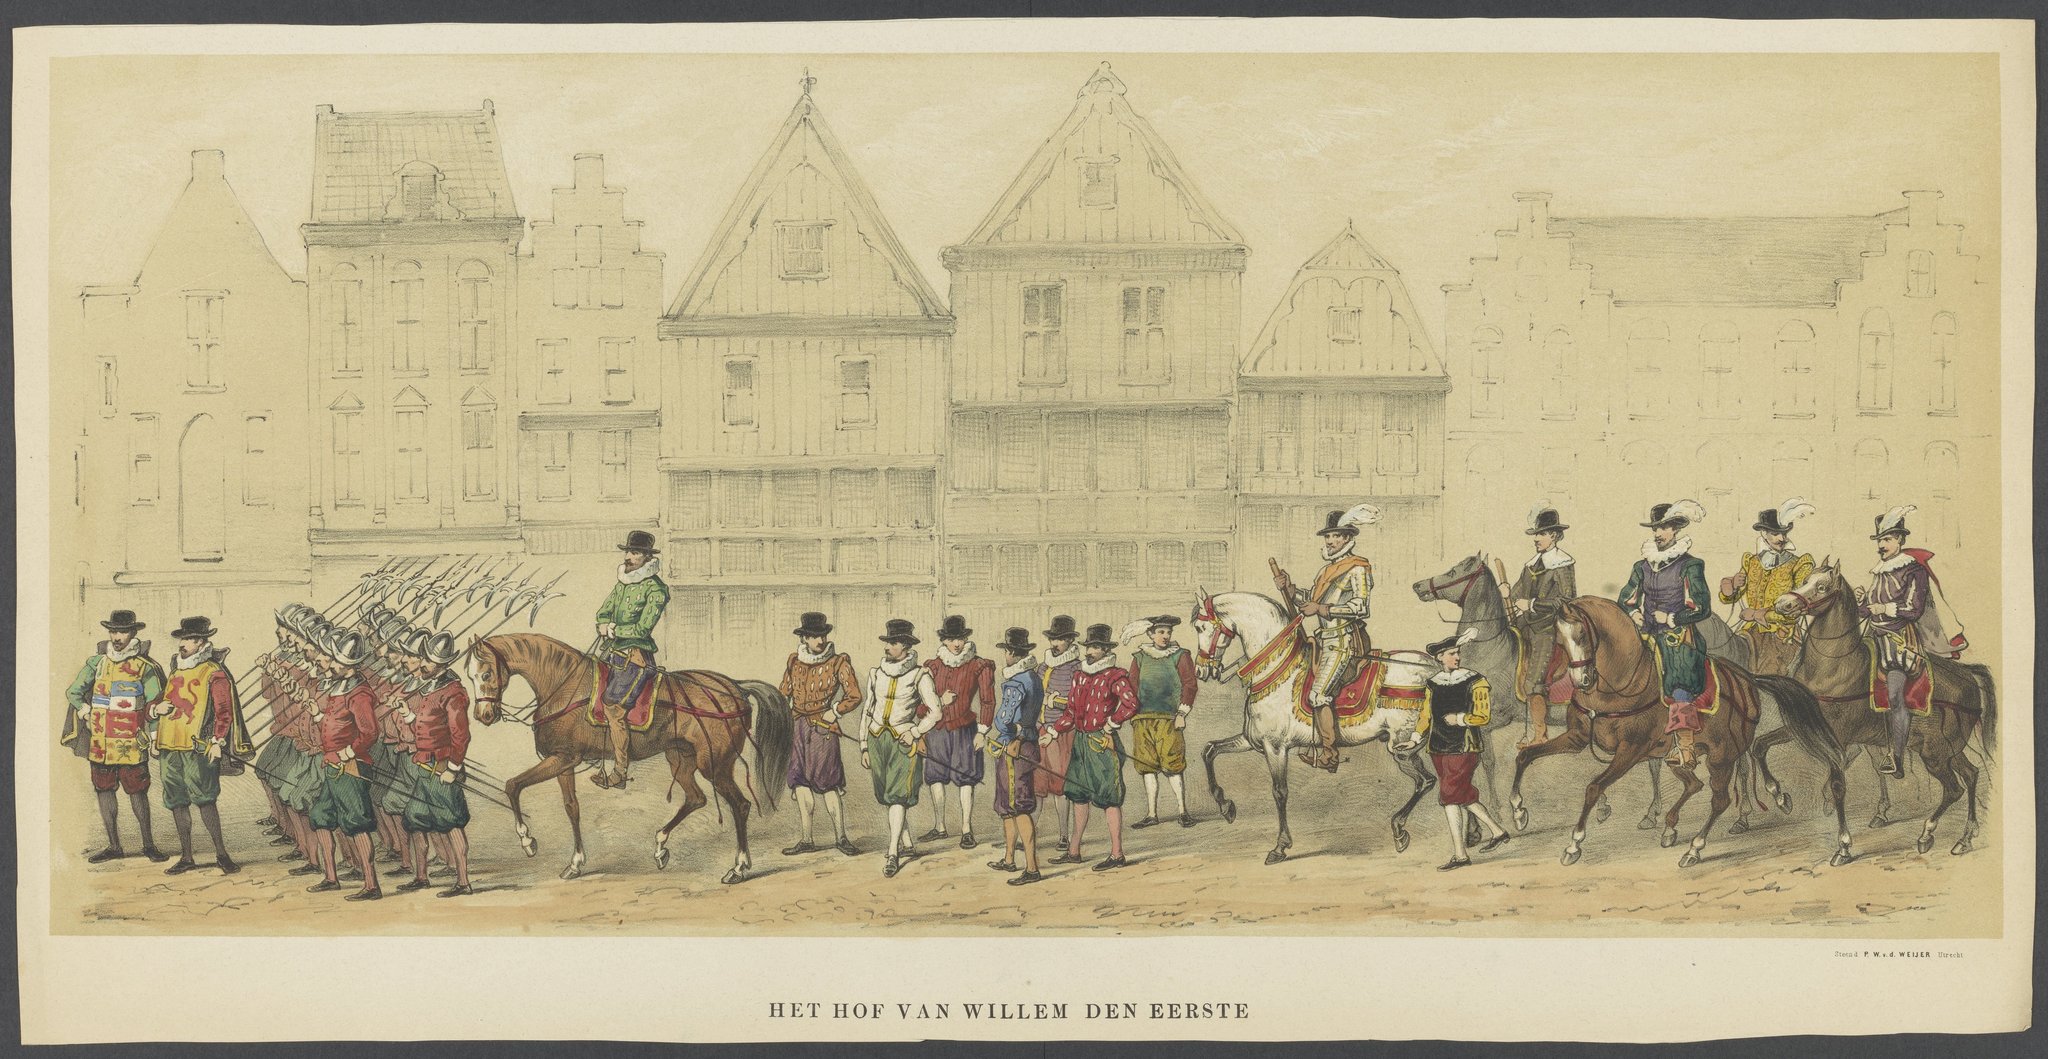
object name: print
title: Het Hof van Willem den Eerste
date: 1856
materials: paper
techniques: hand coloring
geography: utrecht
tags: william i (prince of orange), students' pageant, costumes used in pageants, utrecht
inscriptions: collector's mark: Lugt 2228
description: Het Hof van Willem van Oranje, deel één: voetvolk en ruiters. Onderdeel van een groep van vijf platen met verklaring van de historische optocht in maskerade opgevoerd door de studenten van de Utrechtse Hogeschool op 17 juni 1856 ter gelegenheid van de viering van haar 220-jarige bestaan.